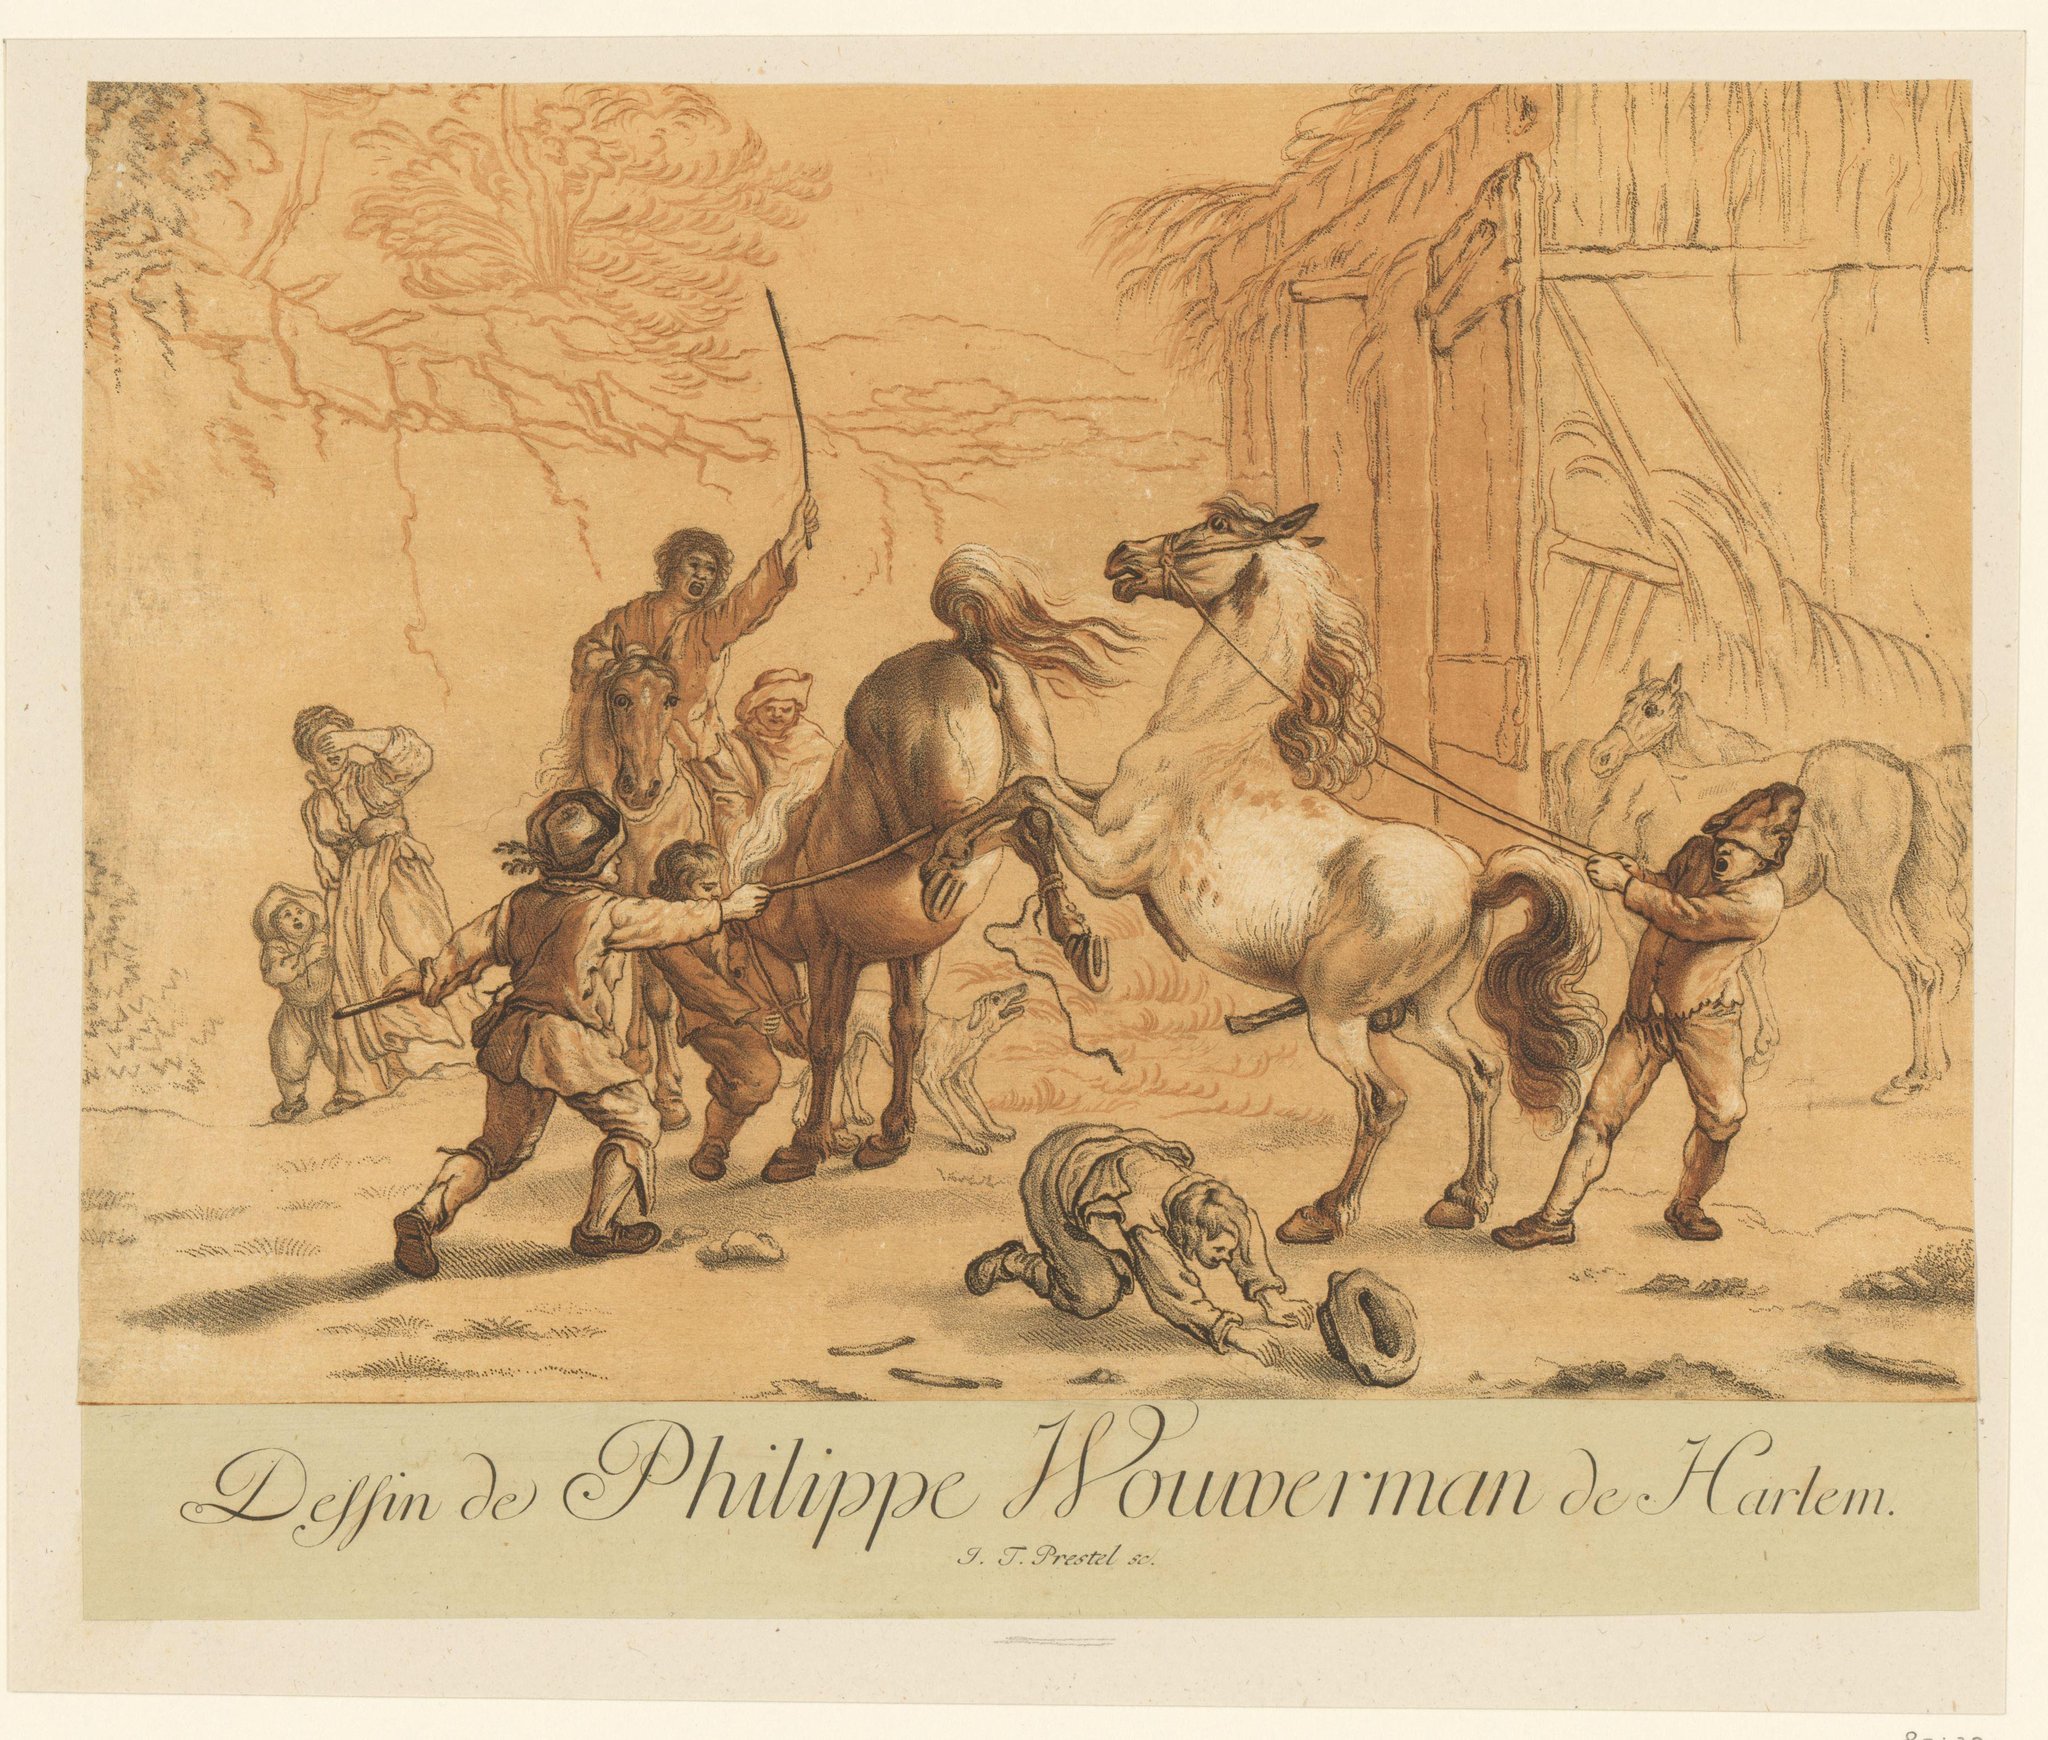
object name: print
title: Steigerende paarden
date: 1749-1808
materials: paper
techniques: printing, printmaking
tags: taming of wild horses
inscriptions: collector's mark: Lugt 2760, collector's mark: Lugt 2228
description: Nummer 3 uit het prentenalbum 'Dessins des meilleurs peintres des Pais-Bas, d'Allemagne et d'Italie : du Cabinet de Gérard Joachim Schmidt à Hambourg. Gravé d'après les originaux par Jean Théophile Prestel'. Wenen: Artaria et Comp., 1779.